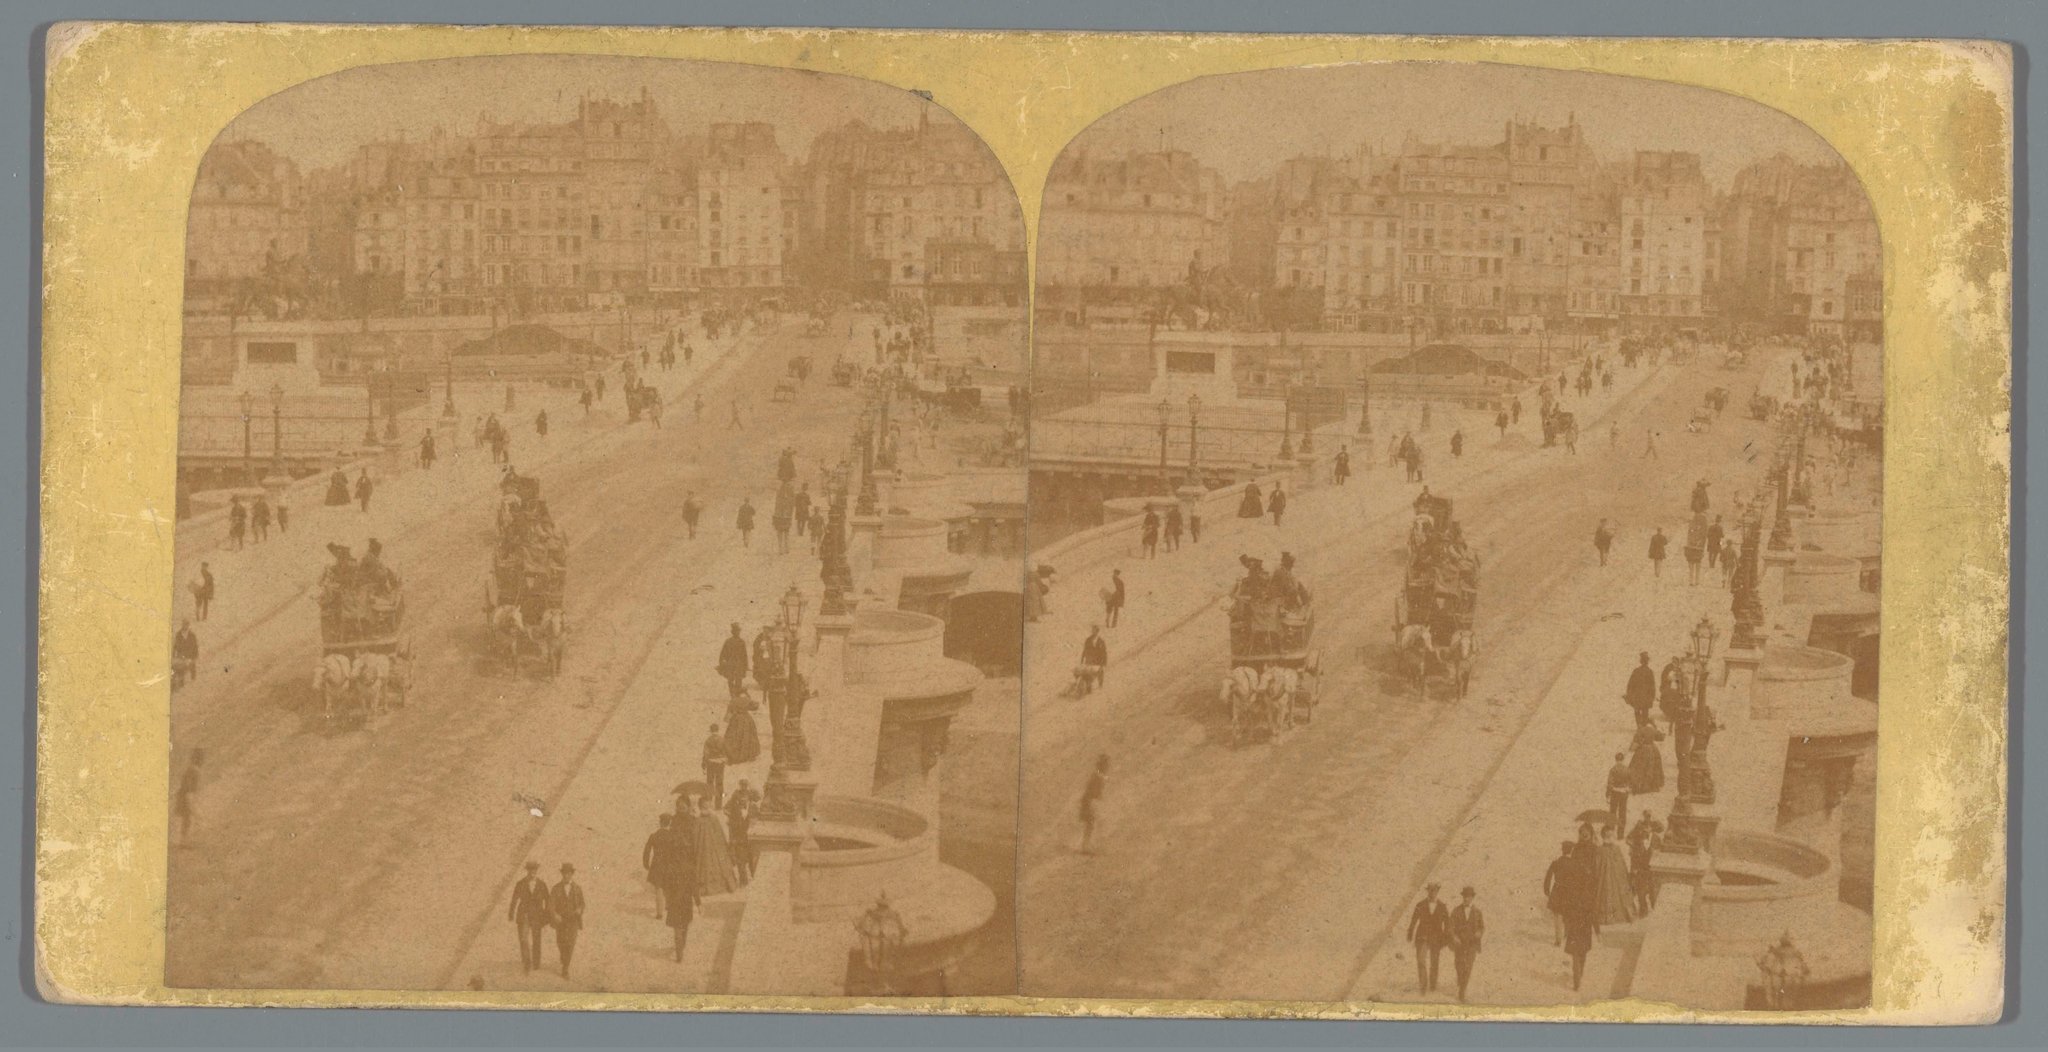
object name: stereograph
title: Gezicht op de Pont Neuf in Parijs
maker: Anonymous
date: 1850-1880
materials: cardboard, photographic support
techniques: albumen print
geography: paris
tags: animal traction, animal-drawn vehicle (carriage etc.), bridge in city across river, canal, etc.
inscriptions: number: ‘No. 28’, inscription: ‘1862 (no 145 [..] refer suis [...] fête [...] du 25 juinr 1863’